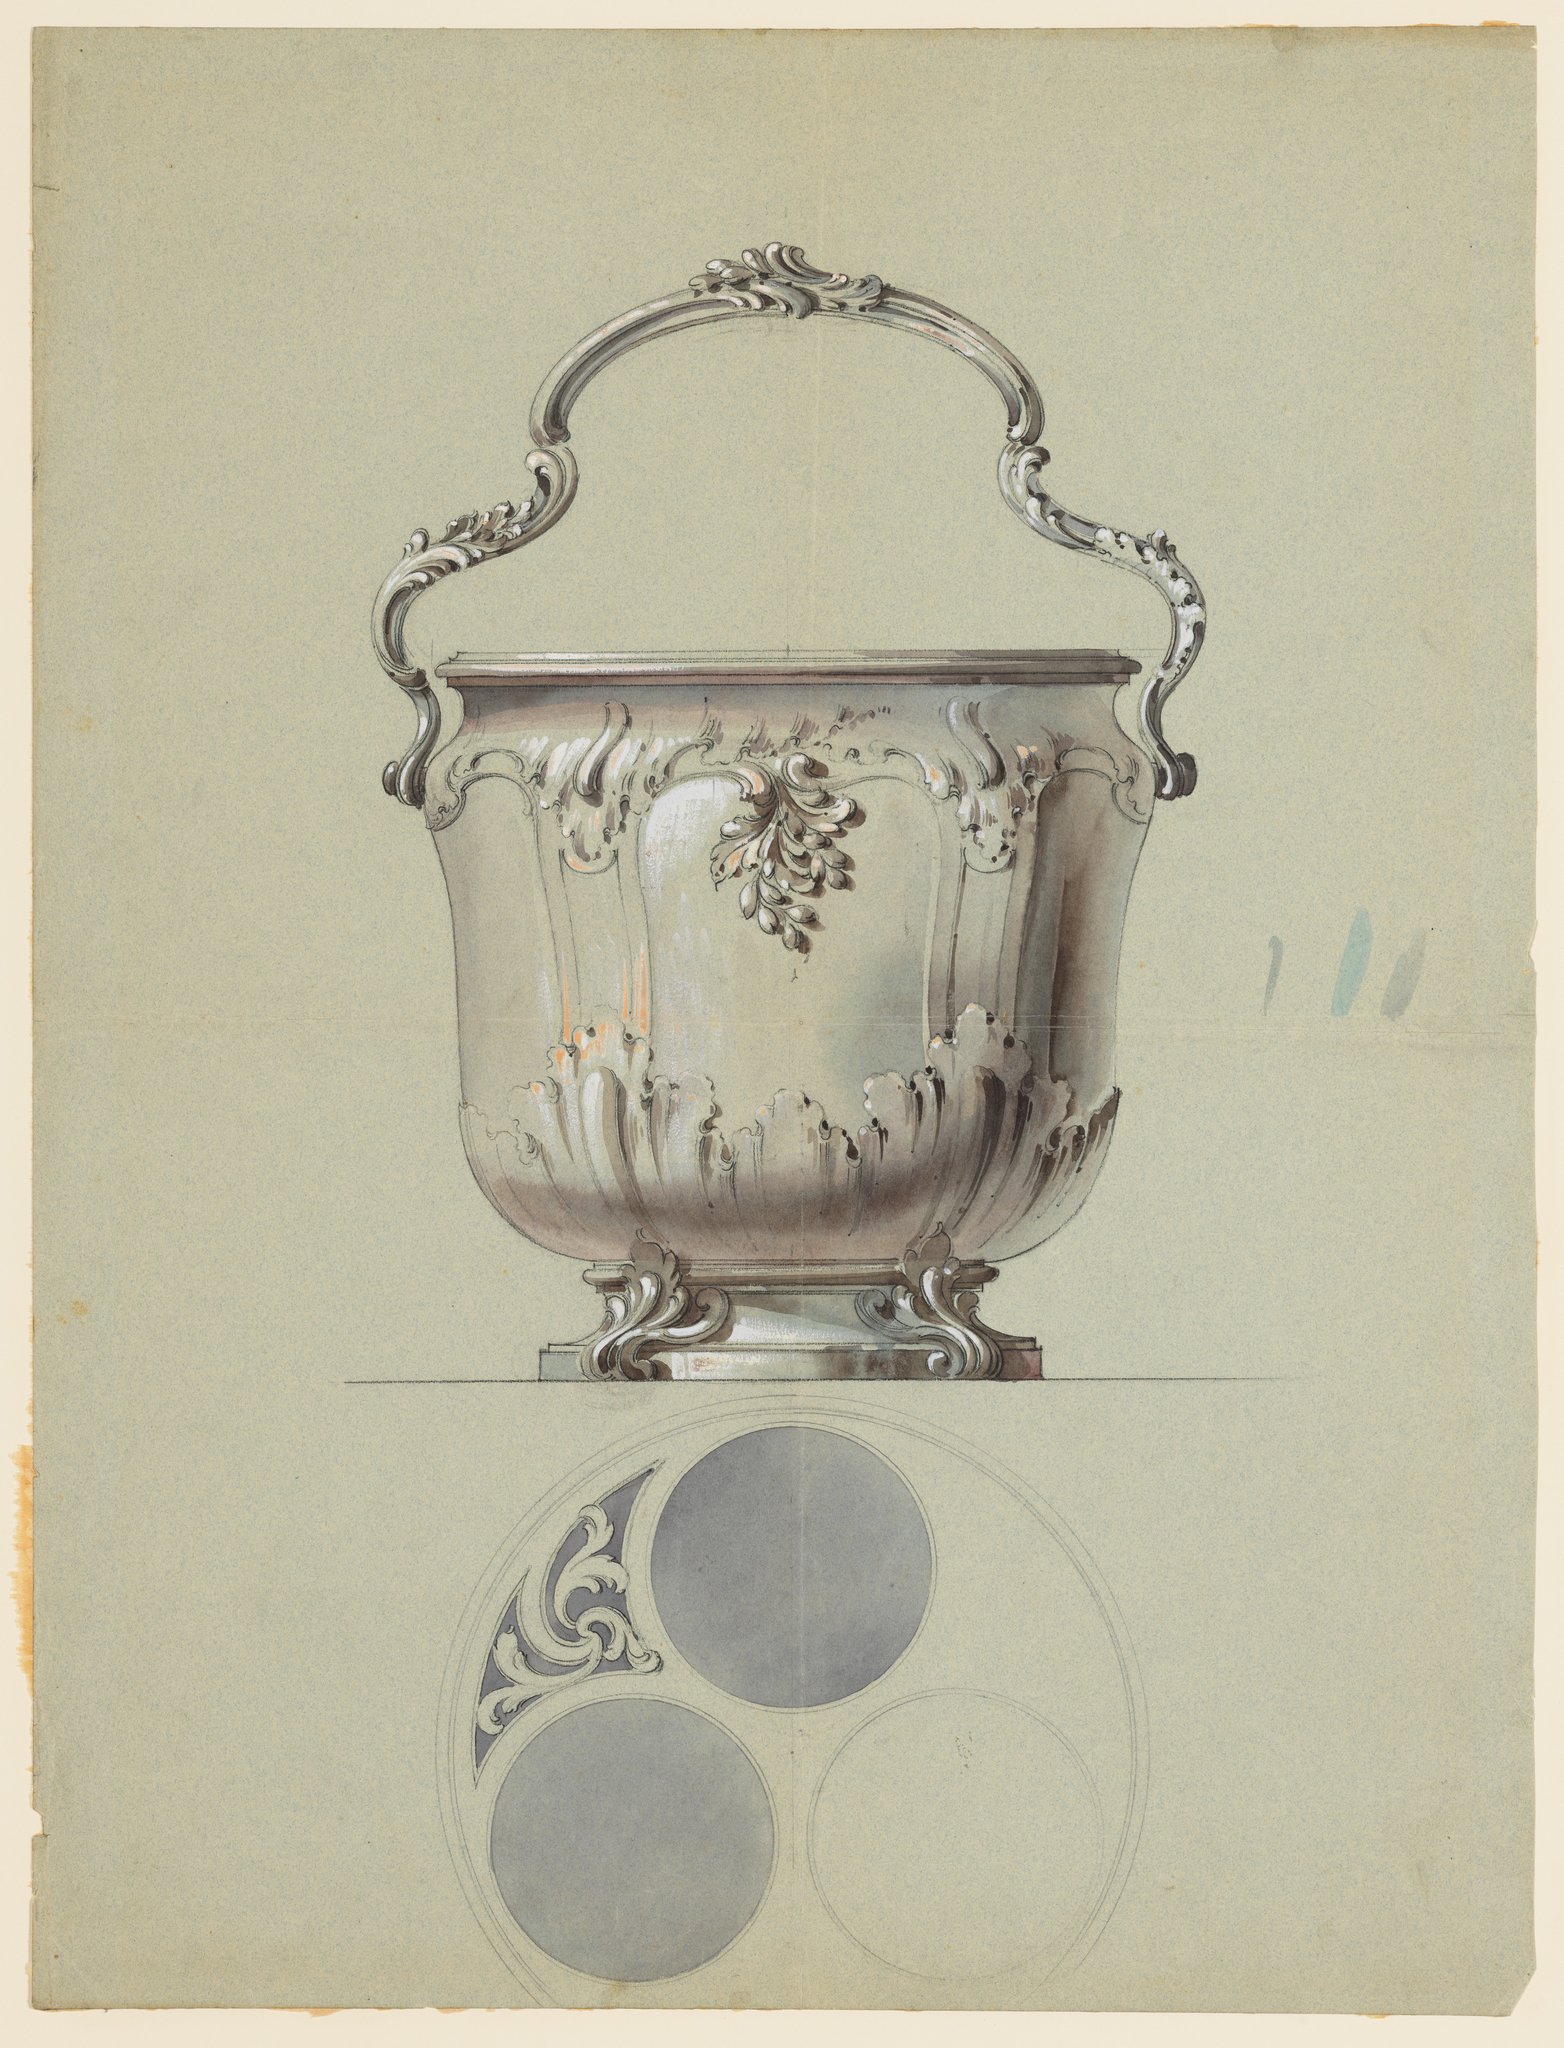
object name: ornament architecture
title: Design for a Silver Vessel (Wine Cooler?)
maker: anonymous, french, 19th century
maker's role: artist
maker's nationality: french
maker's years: 1800-1900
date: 1801-1900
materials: chalk, gouache, graphite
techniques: brush, heightening, wash